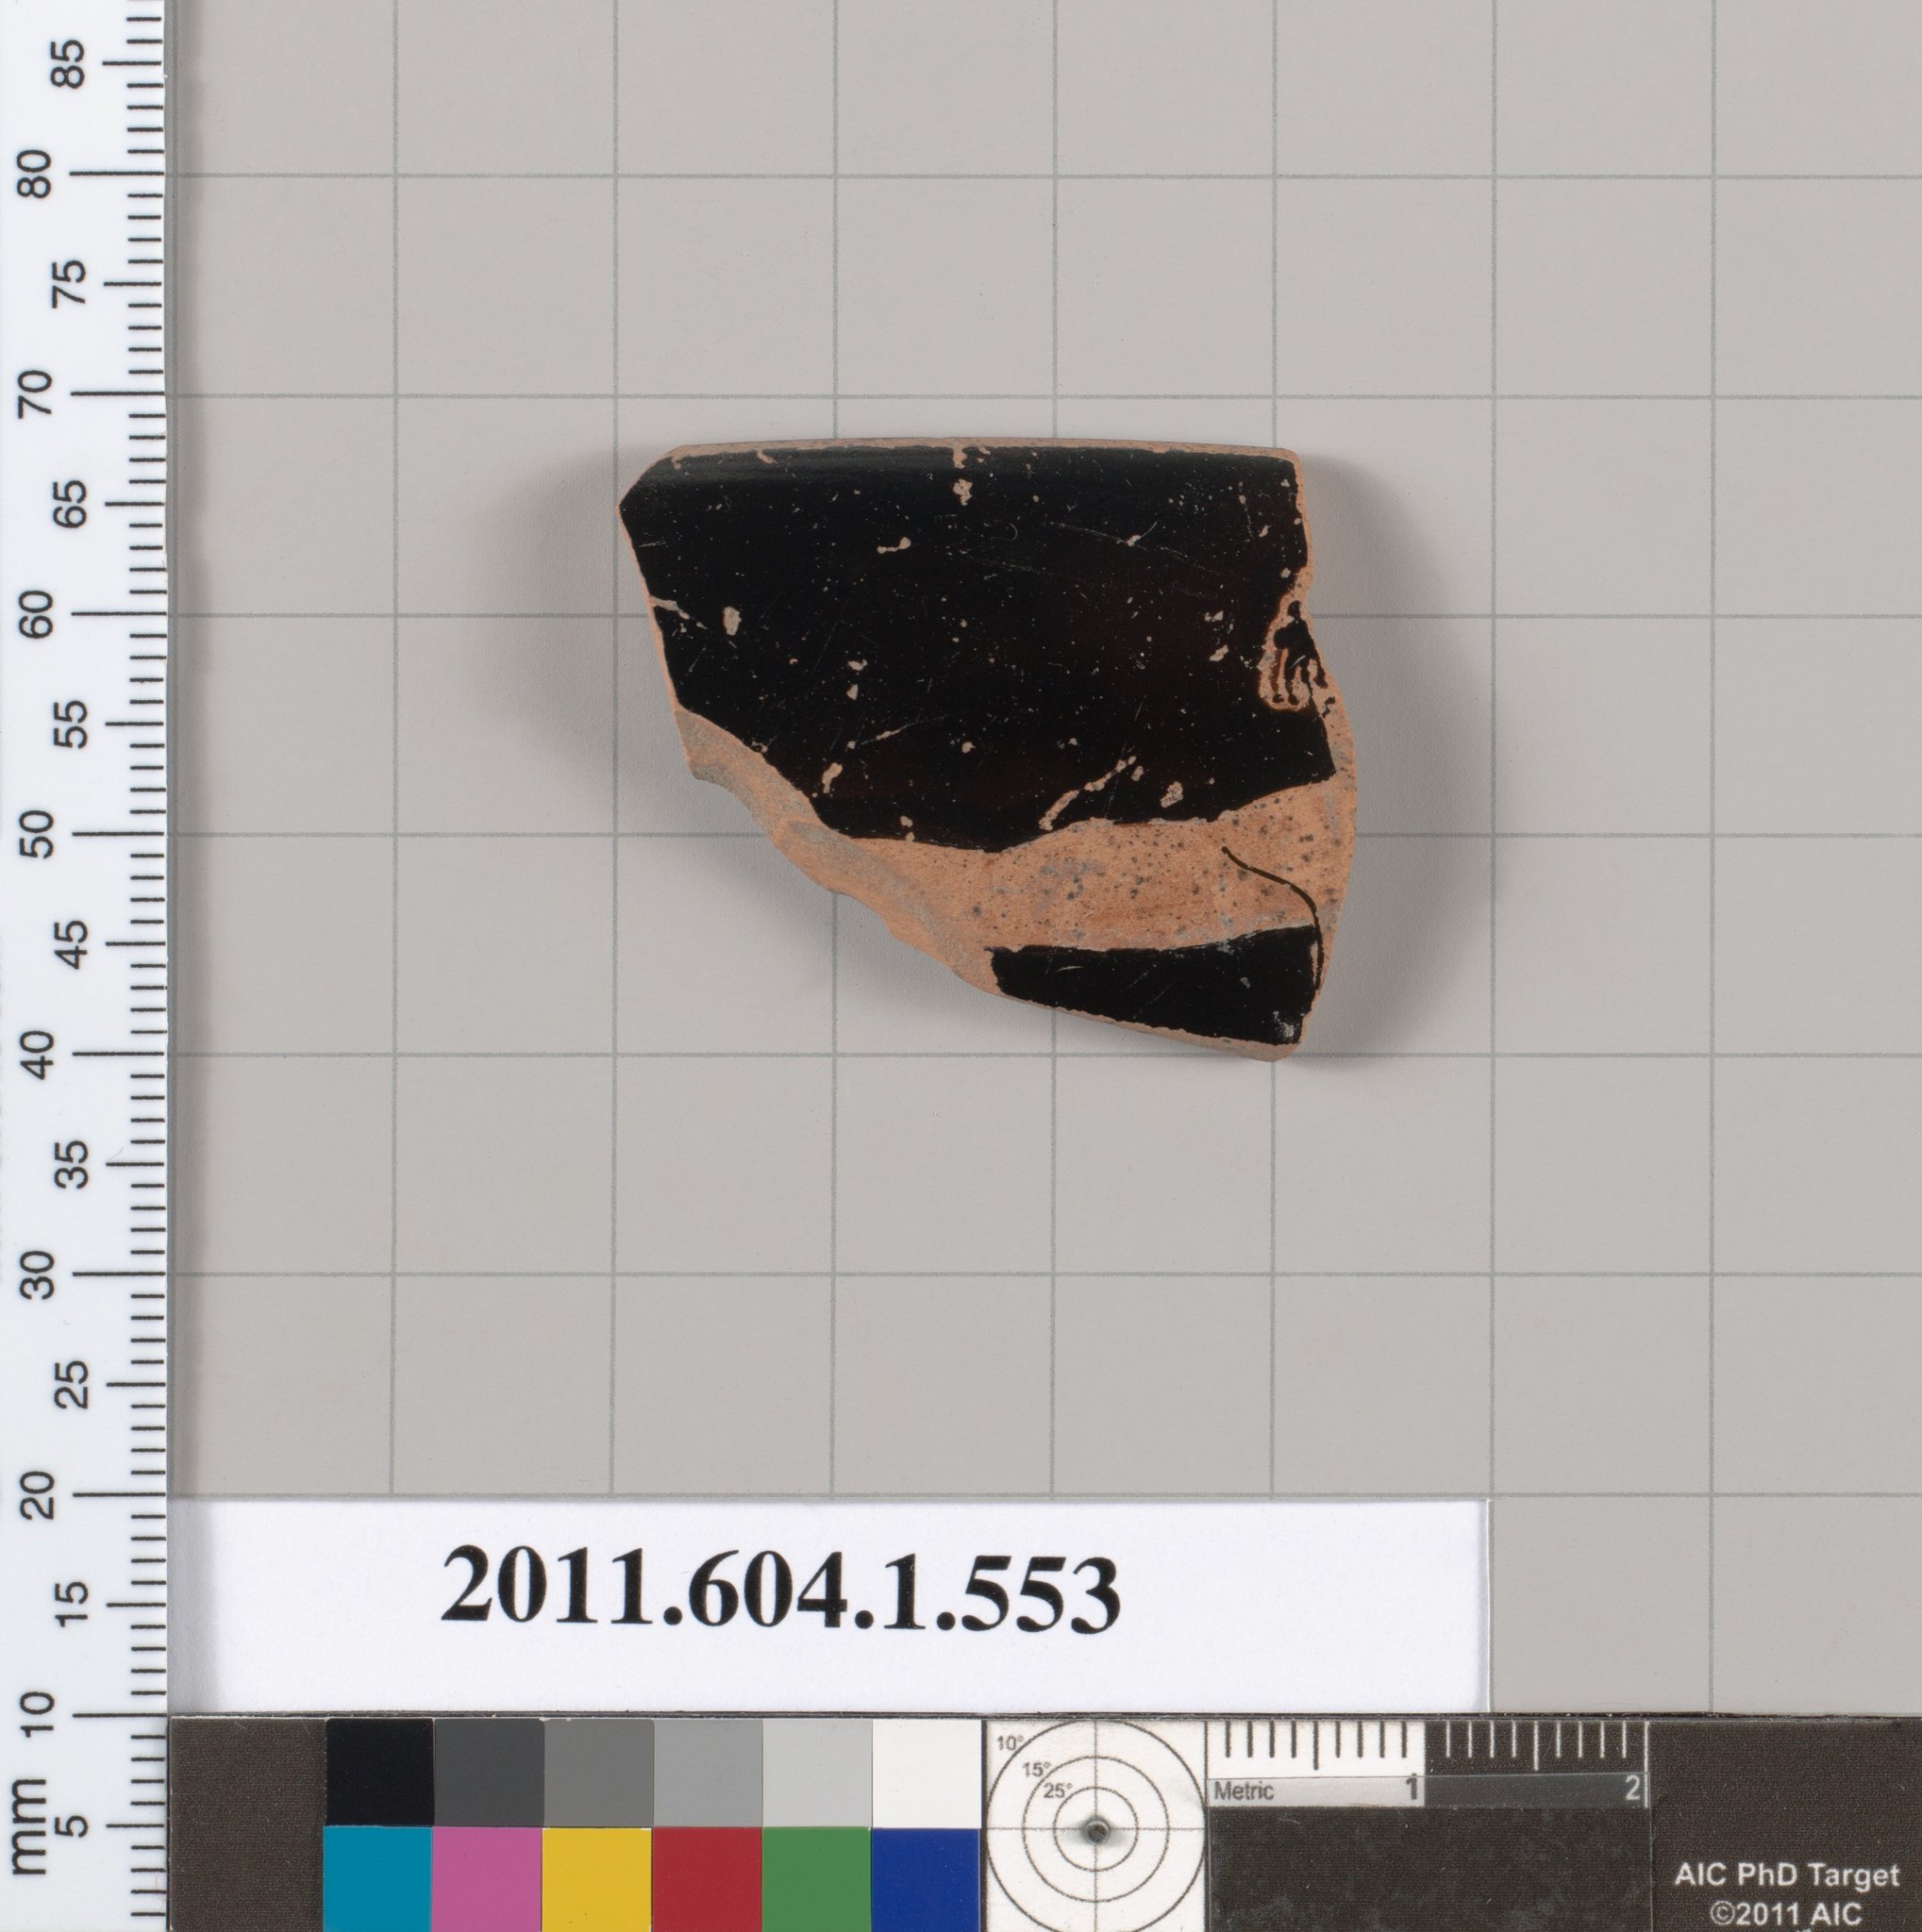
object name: kylix fragment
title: Terracotta rim fragment of a kylix (drinking cup)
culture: greek, attic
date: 480-470 BCE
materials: terracotta